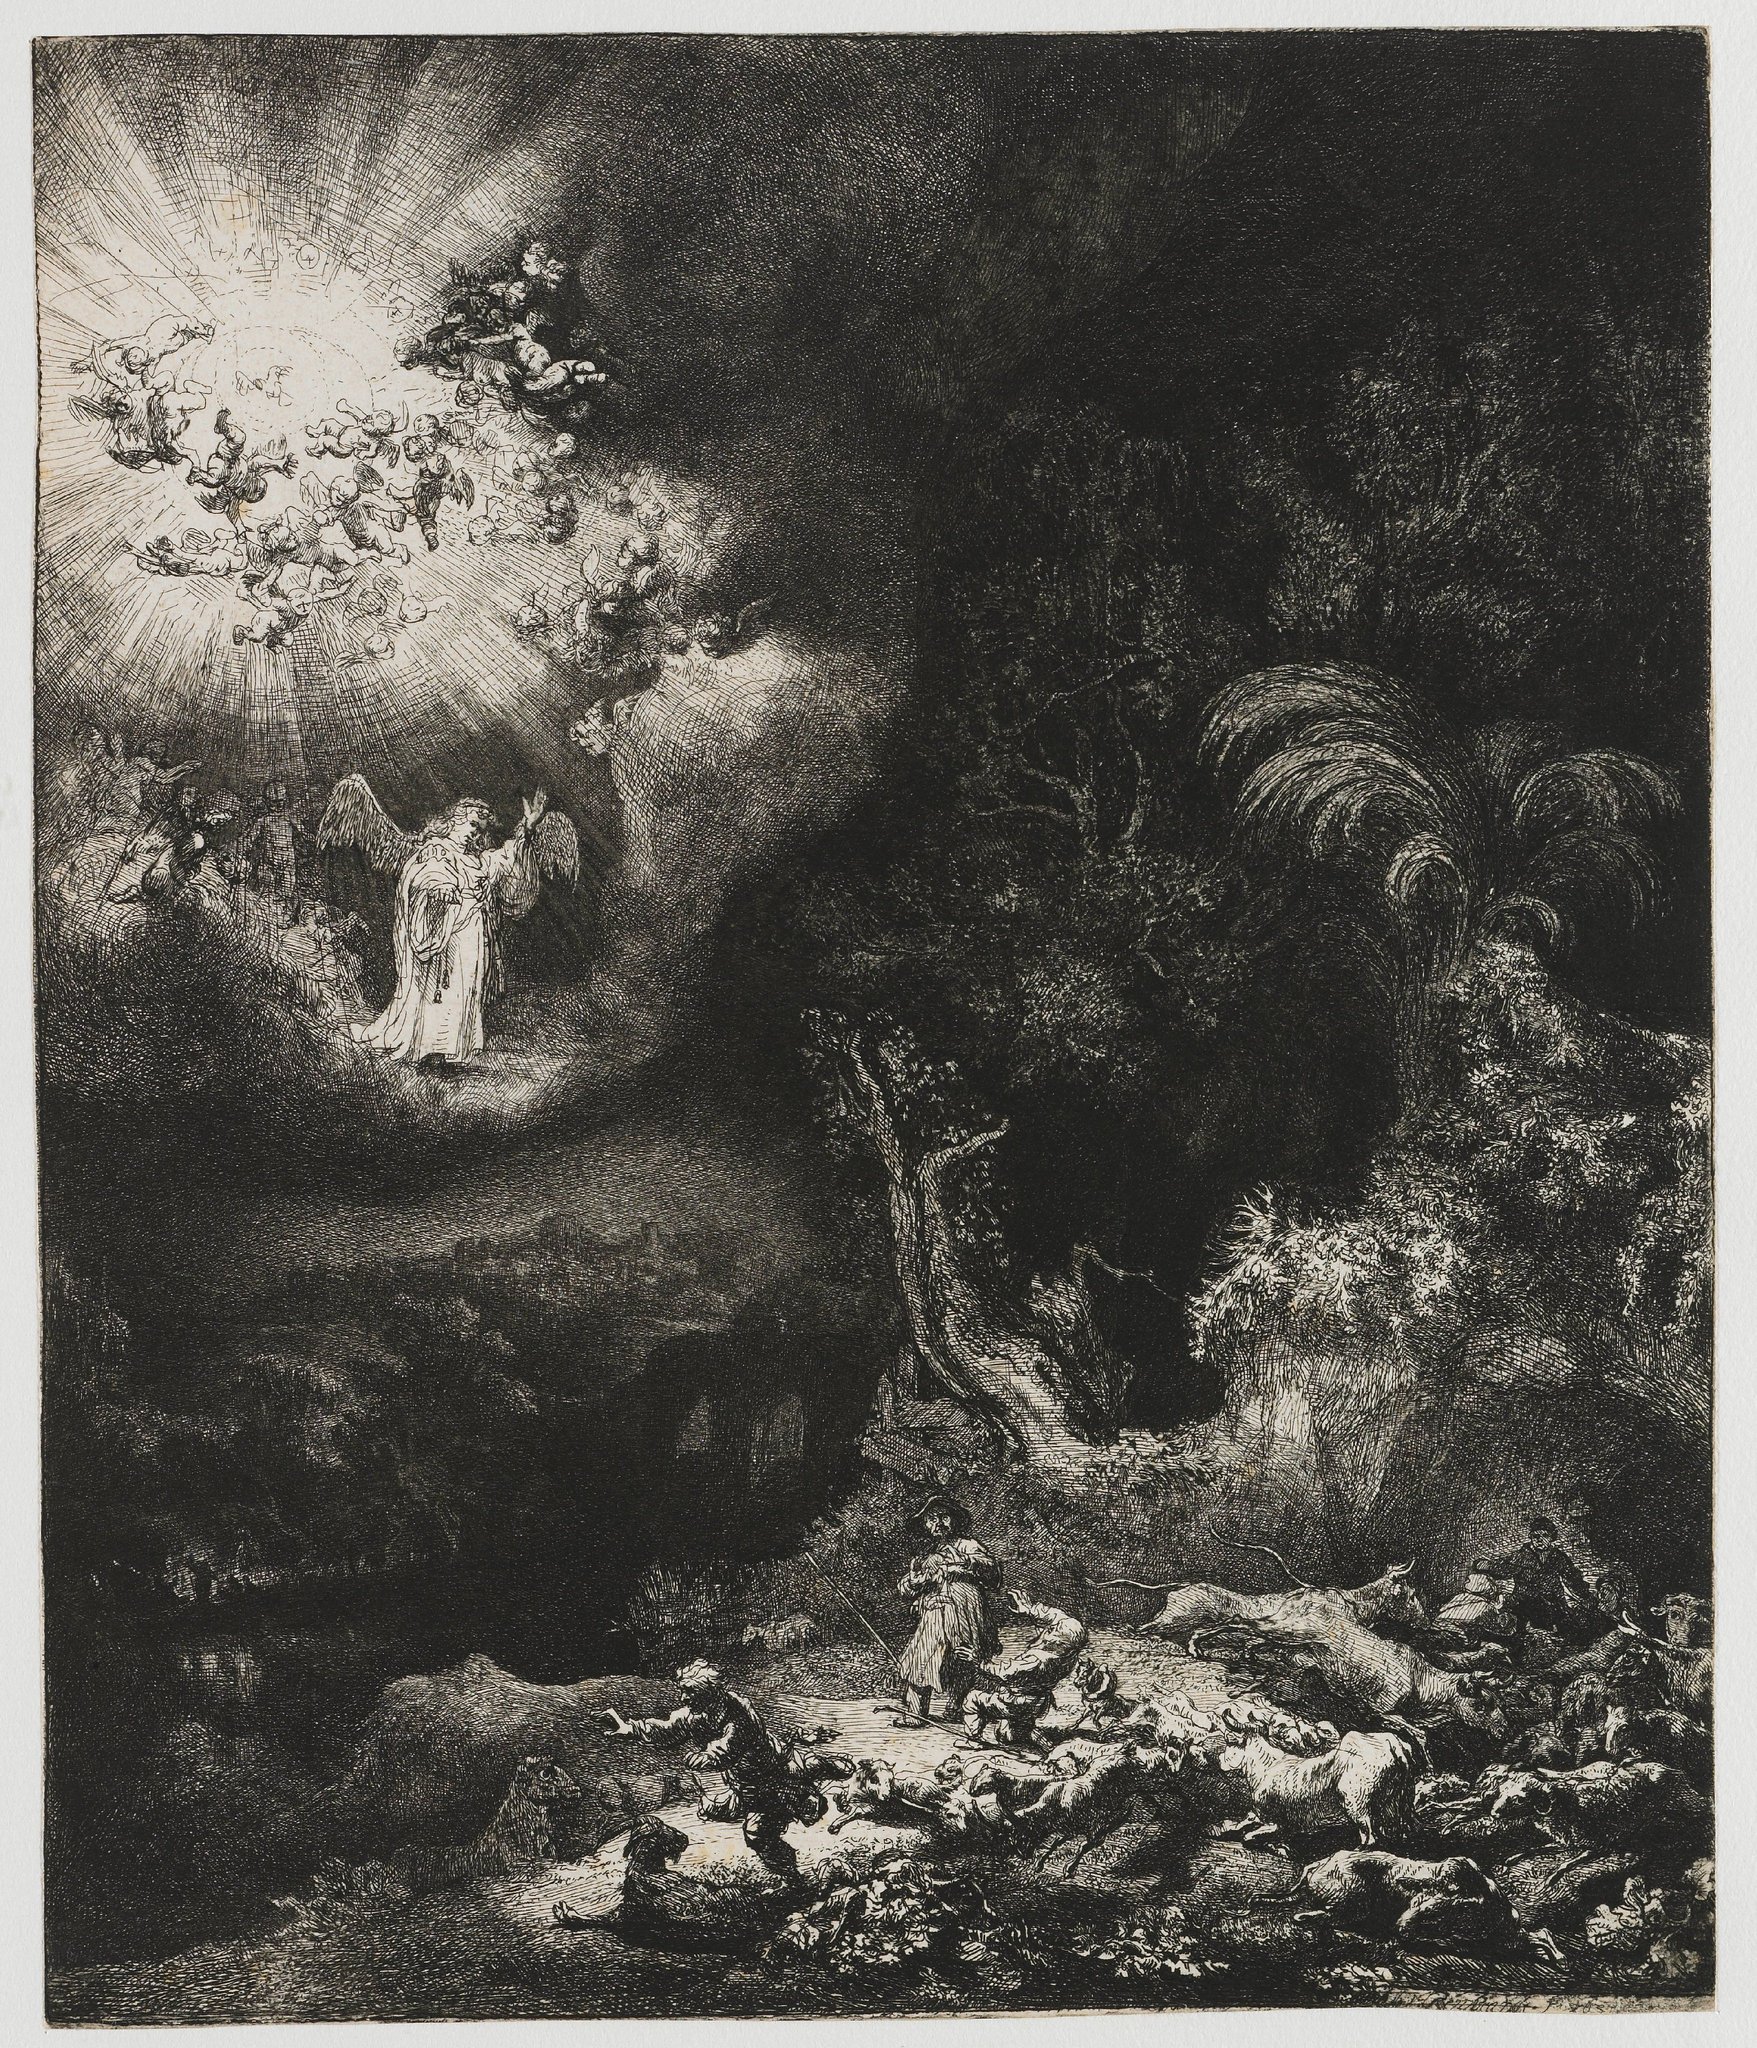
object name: print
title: The Annunciation to the Shepherds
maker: rembrandt van rijn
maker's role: draughtsman, painter, print maker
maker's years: 1606-1669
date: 1634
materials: paper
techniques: drypoint, etching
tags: annunciation of christ's birth to the shepherds (and/or shepherdesses) at night; a host of singing angels in the air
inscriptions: signature and date: ‘Rembrandt f. 1634’, mark: Lugt 2228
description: Rembrandt displays a penchant for drama in his early work from the 1630s. This is evident here, too, in his first etched nocturnal scene. An angel surrounded by divine light announces the glad tidings of Christ’s birth. Sheer panic breaks out on the ground below: the cattle bolt in all directions, and the shepherds are in a state of commotion.